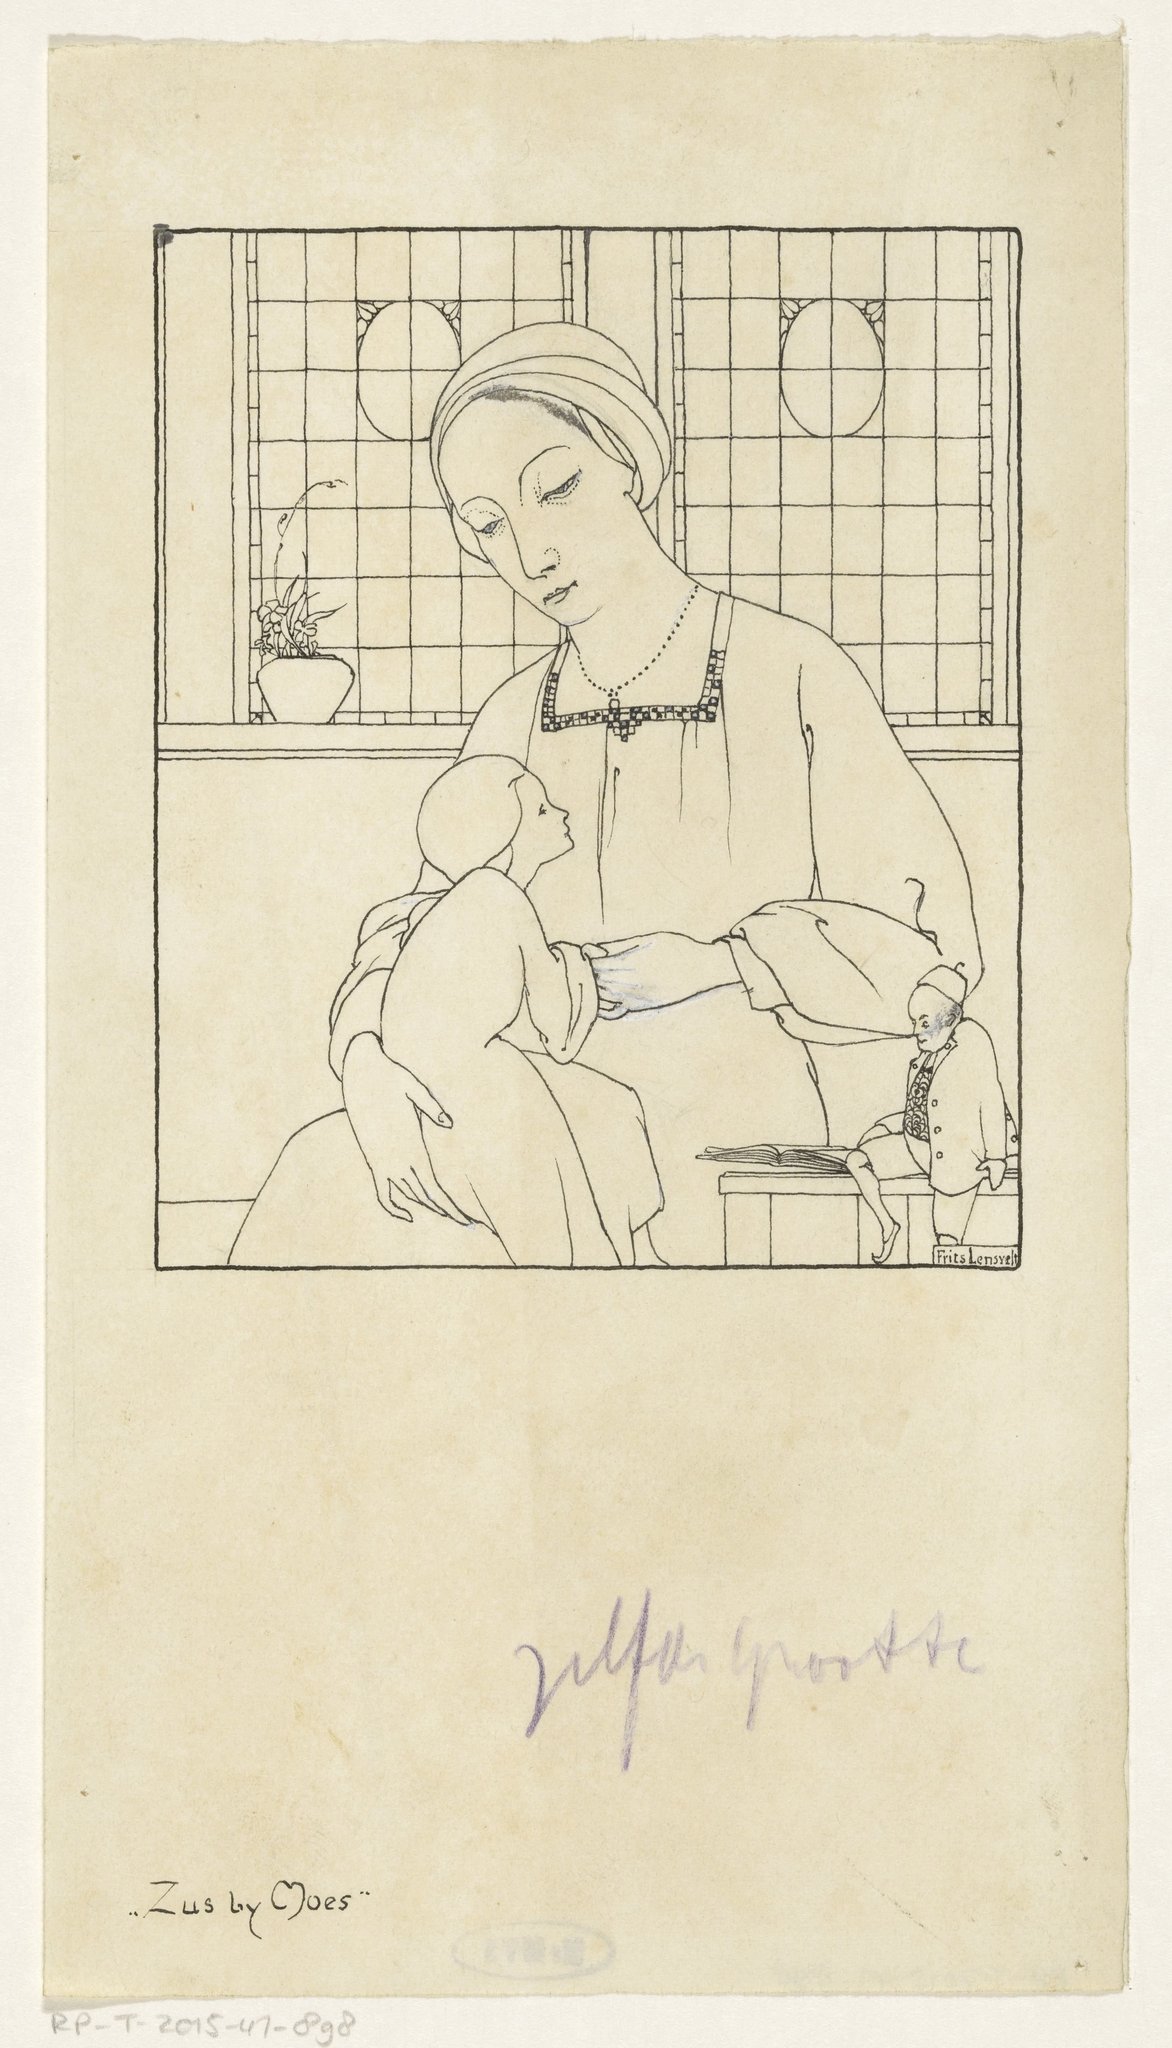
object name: boekillustratie ontwerp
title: Vrouw met kind op schoot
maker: frits lensvelt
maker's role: draughtsman, print maker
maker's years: 1886-1945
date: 1910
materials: paint, ink, paper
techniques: brush, pen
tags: window, sitting in someone's lap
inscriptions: collector's mark: Lugt 2228, signature: ‘Frits Lensvelt’, annotation: ‘"Zus bij Moes"’, :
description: Een vrouw met haar haren in een hoofddoek zit bij een glas-in-loodvenster. Ze heeft een kind op schoot en houdt de hand van het kind vast. Op een tafel ligt een boek en zit een miniatuurfiguur gekleed in een pak en gilet met een hoed.